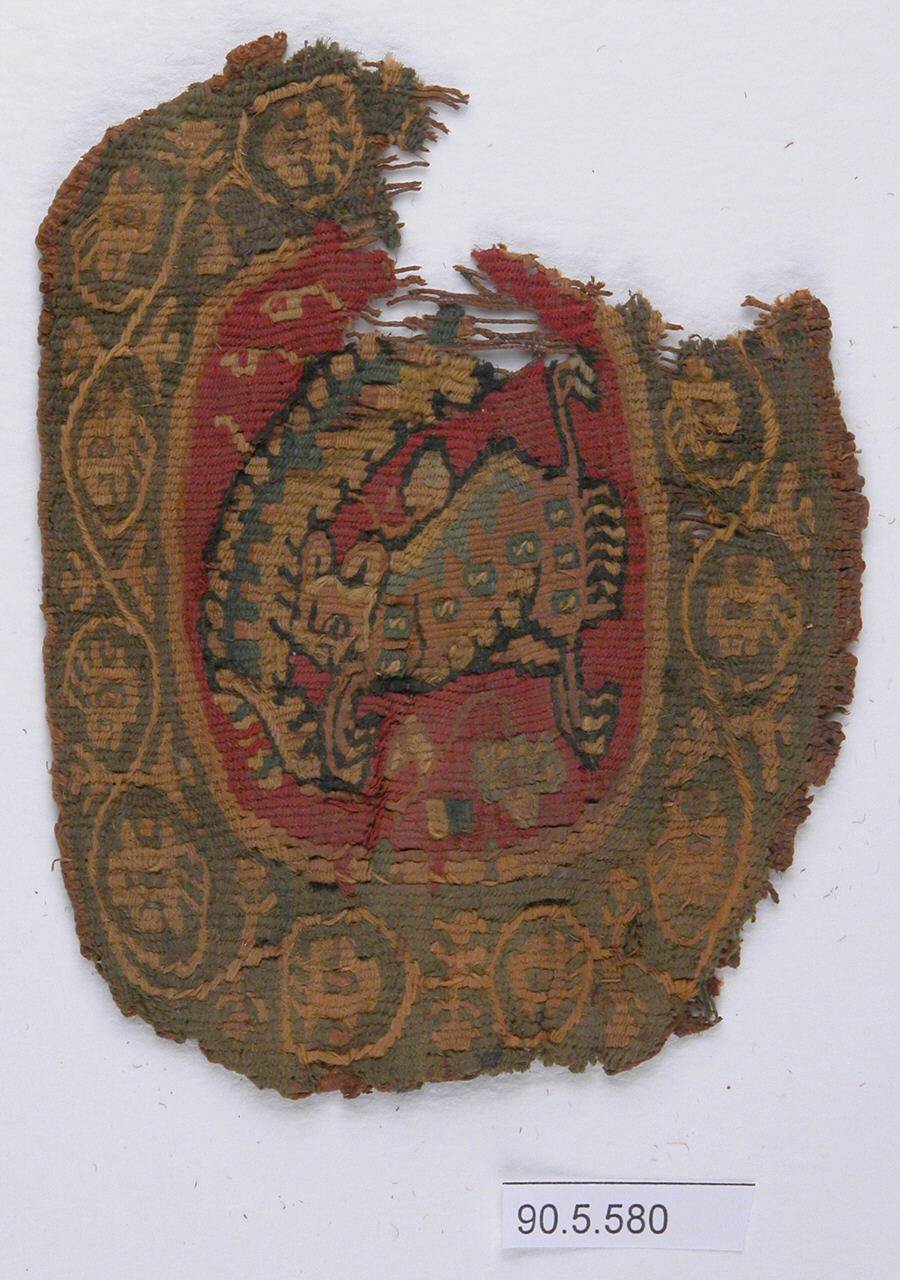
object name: textile fragment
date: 601-800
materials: linen, wool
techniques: weave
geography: egypt